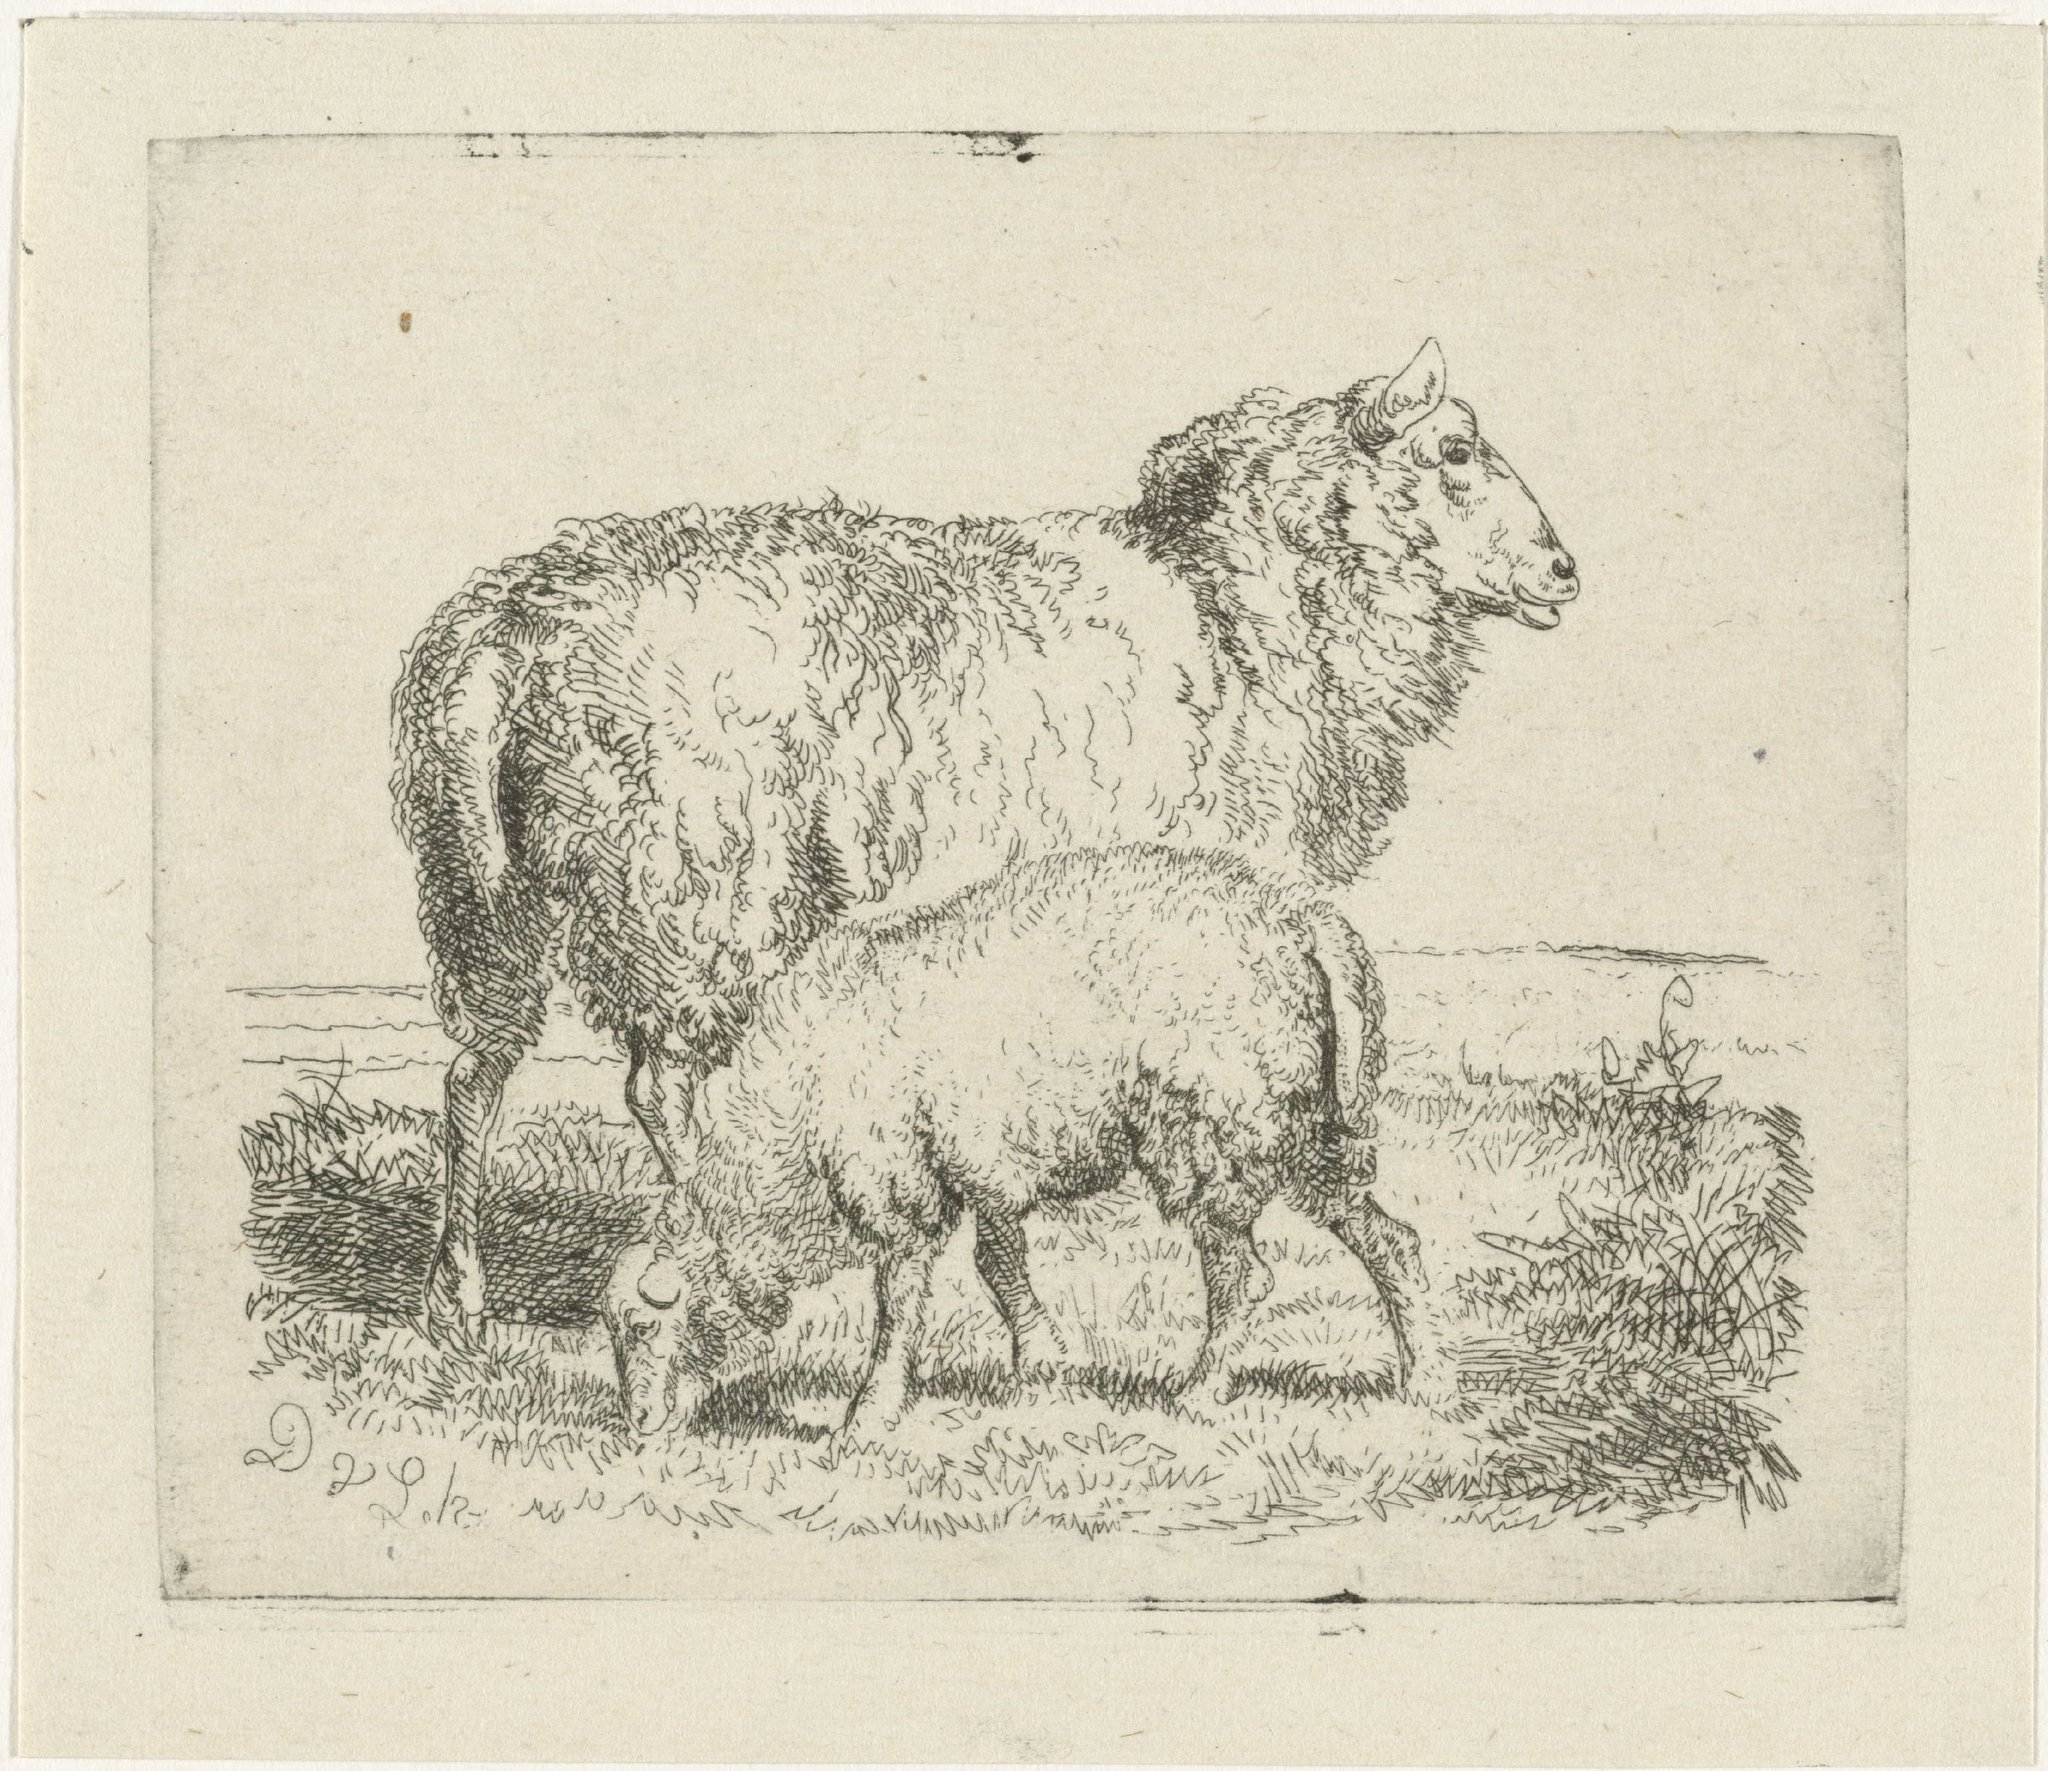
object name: print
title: Schaap met lam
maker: dirk van lokhorst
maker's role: draughtsman, painter, print maker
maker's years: 1818-1893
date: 1828-1893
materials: paper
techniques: etching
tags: lamb, sheep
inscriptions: collector's mark: Lugt 2228